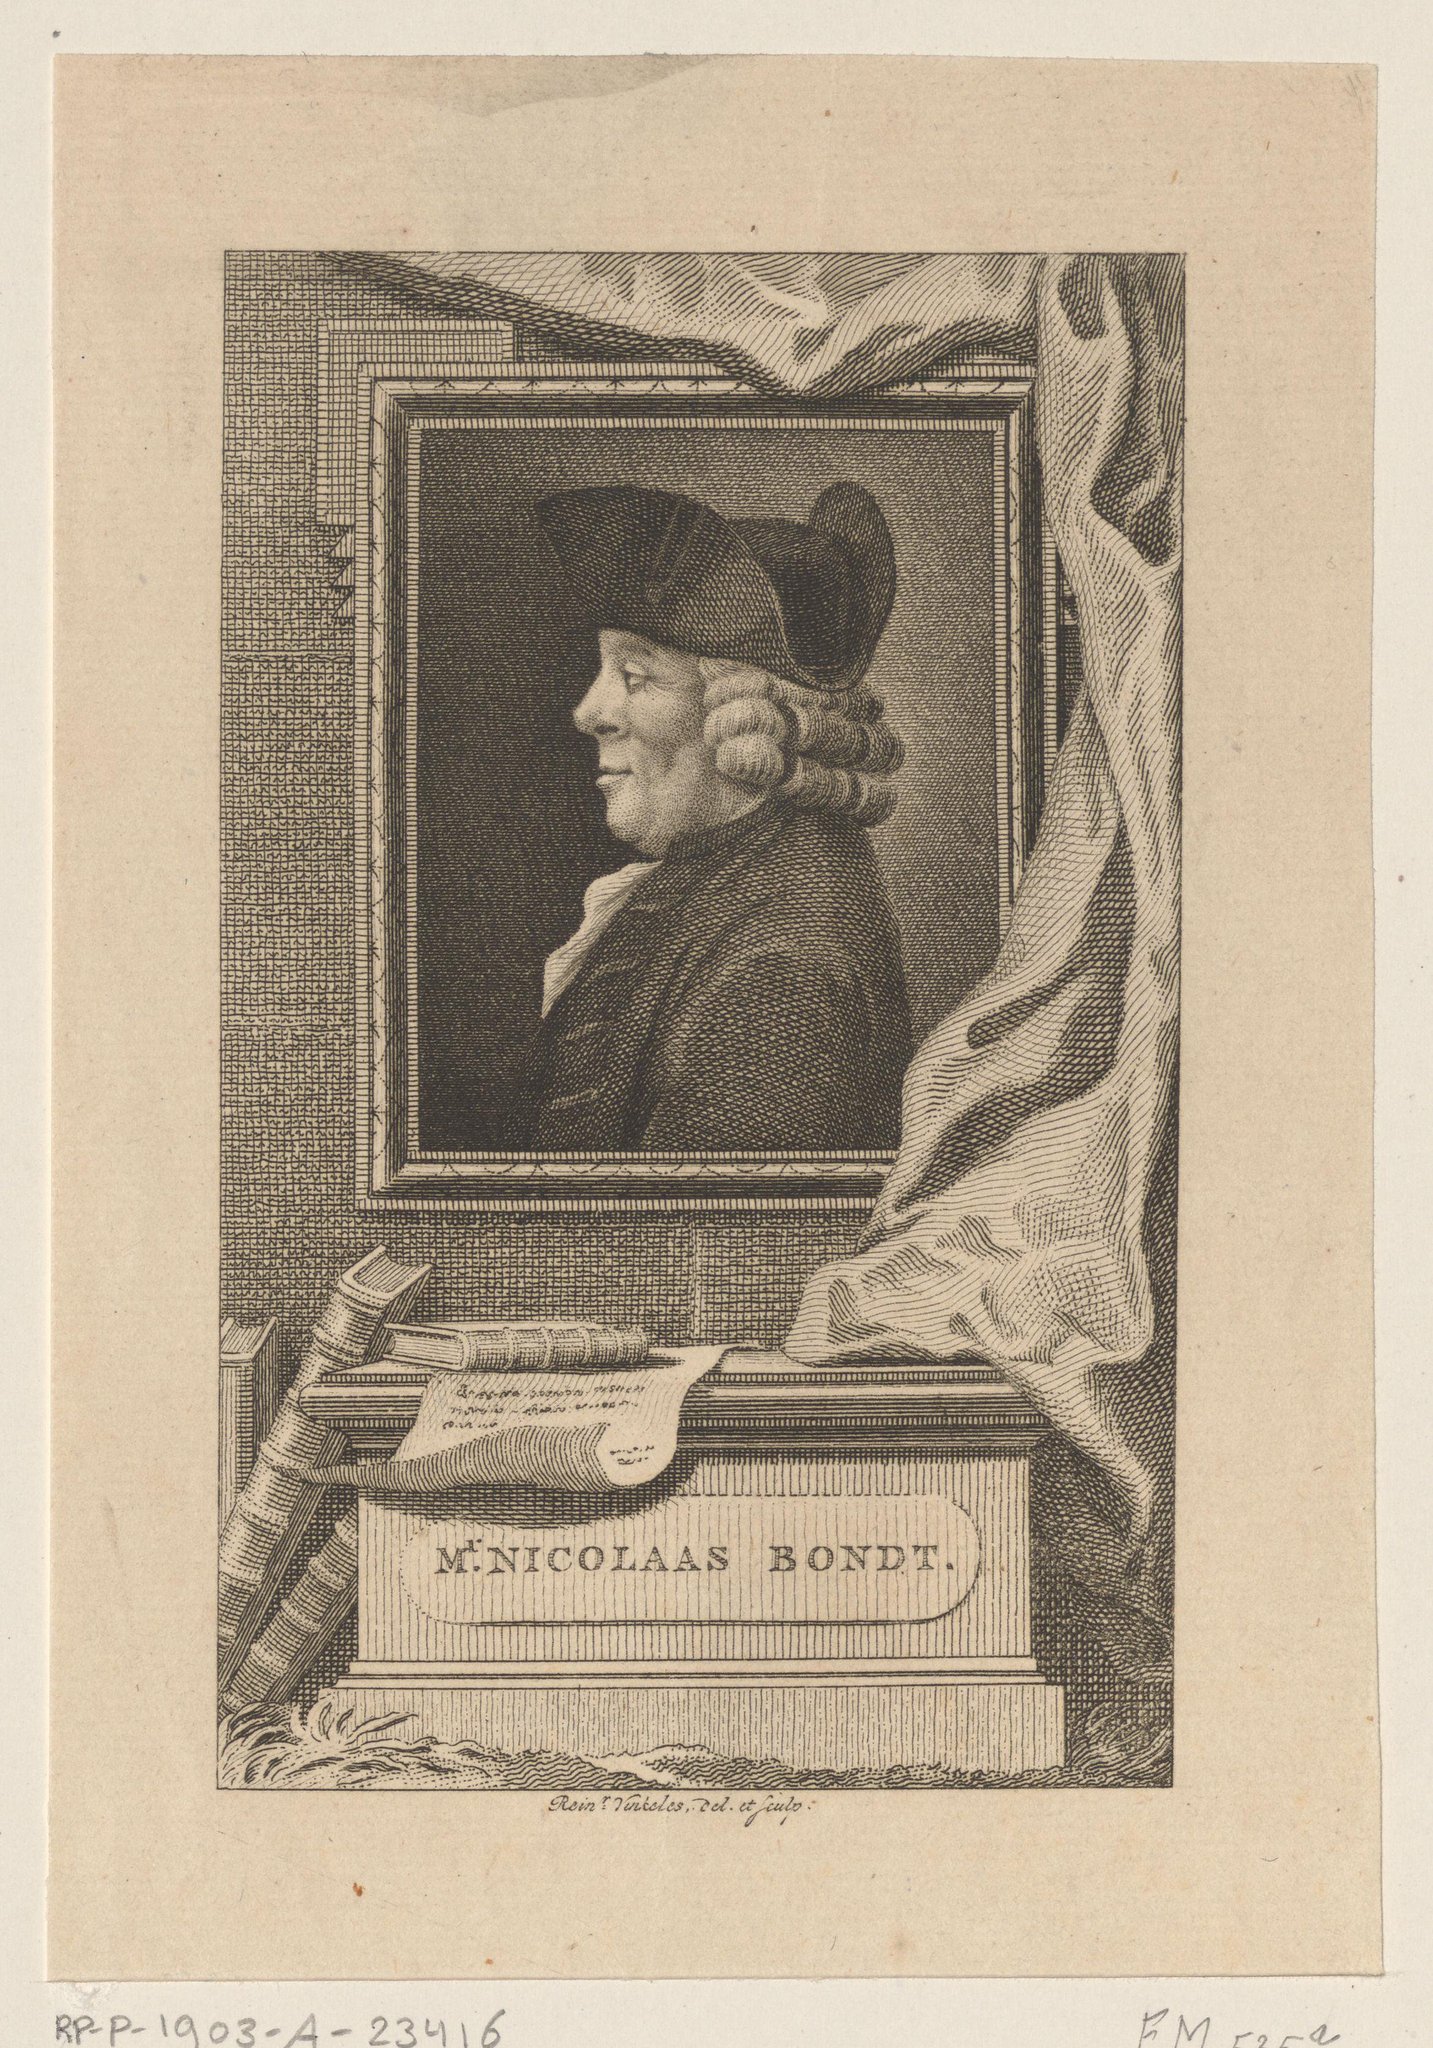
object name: book illustration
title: Portret van Nicolaas Bondt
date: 1786-1811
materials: paper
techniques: etching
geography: amsterdam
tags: amsterdam, historical persons, book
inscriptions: collector's mark: Lugt 2228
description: Prent uit: Loosjes, Petrus. Vaderlandsche historie, (...) ten vervolge van Wagenaars Vaderlandsche historie. Amsterdam: Johannes Allart, 1786-1811, dl. 25.